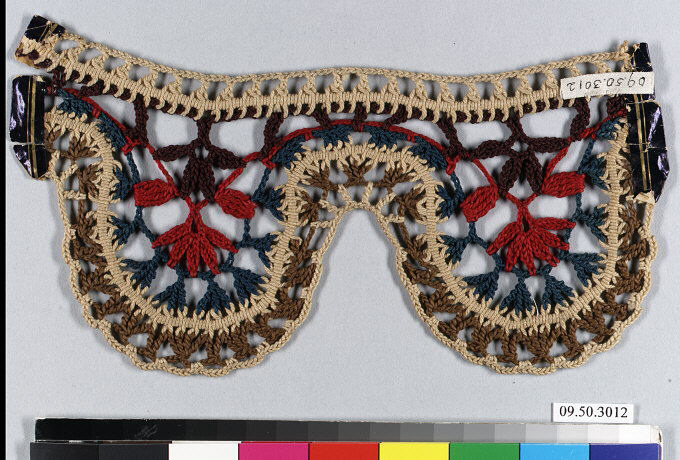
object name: piece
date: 1801-1900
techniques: crochet